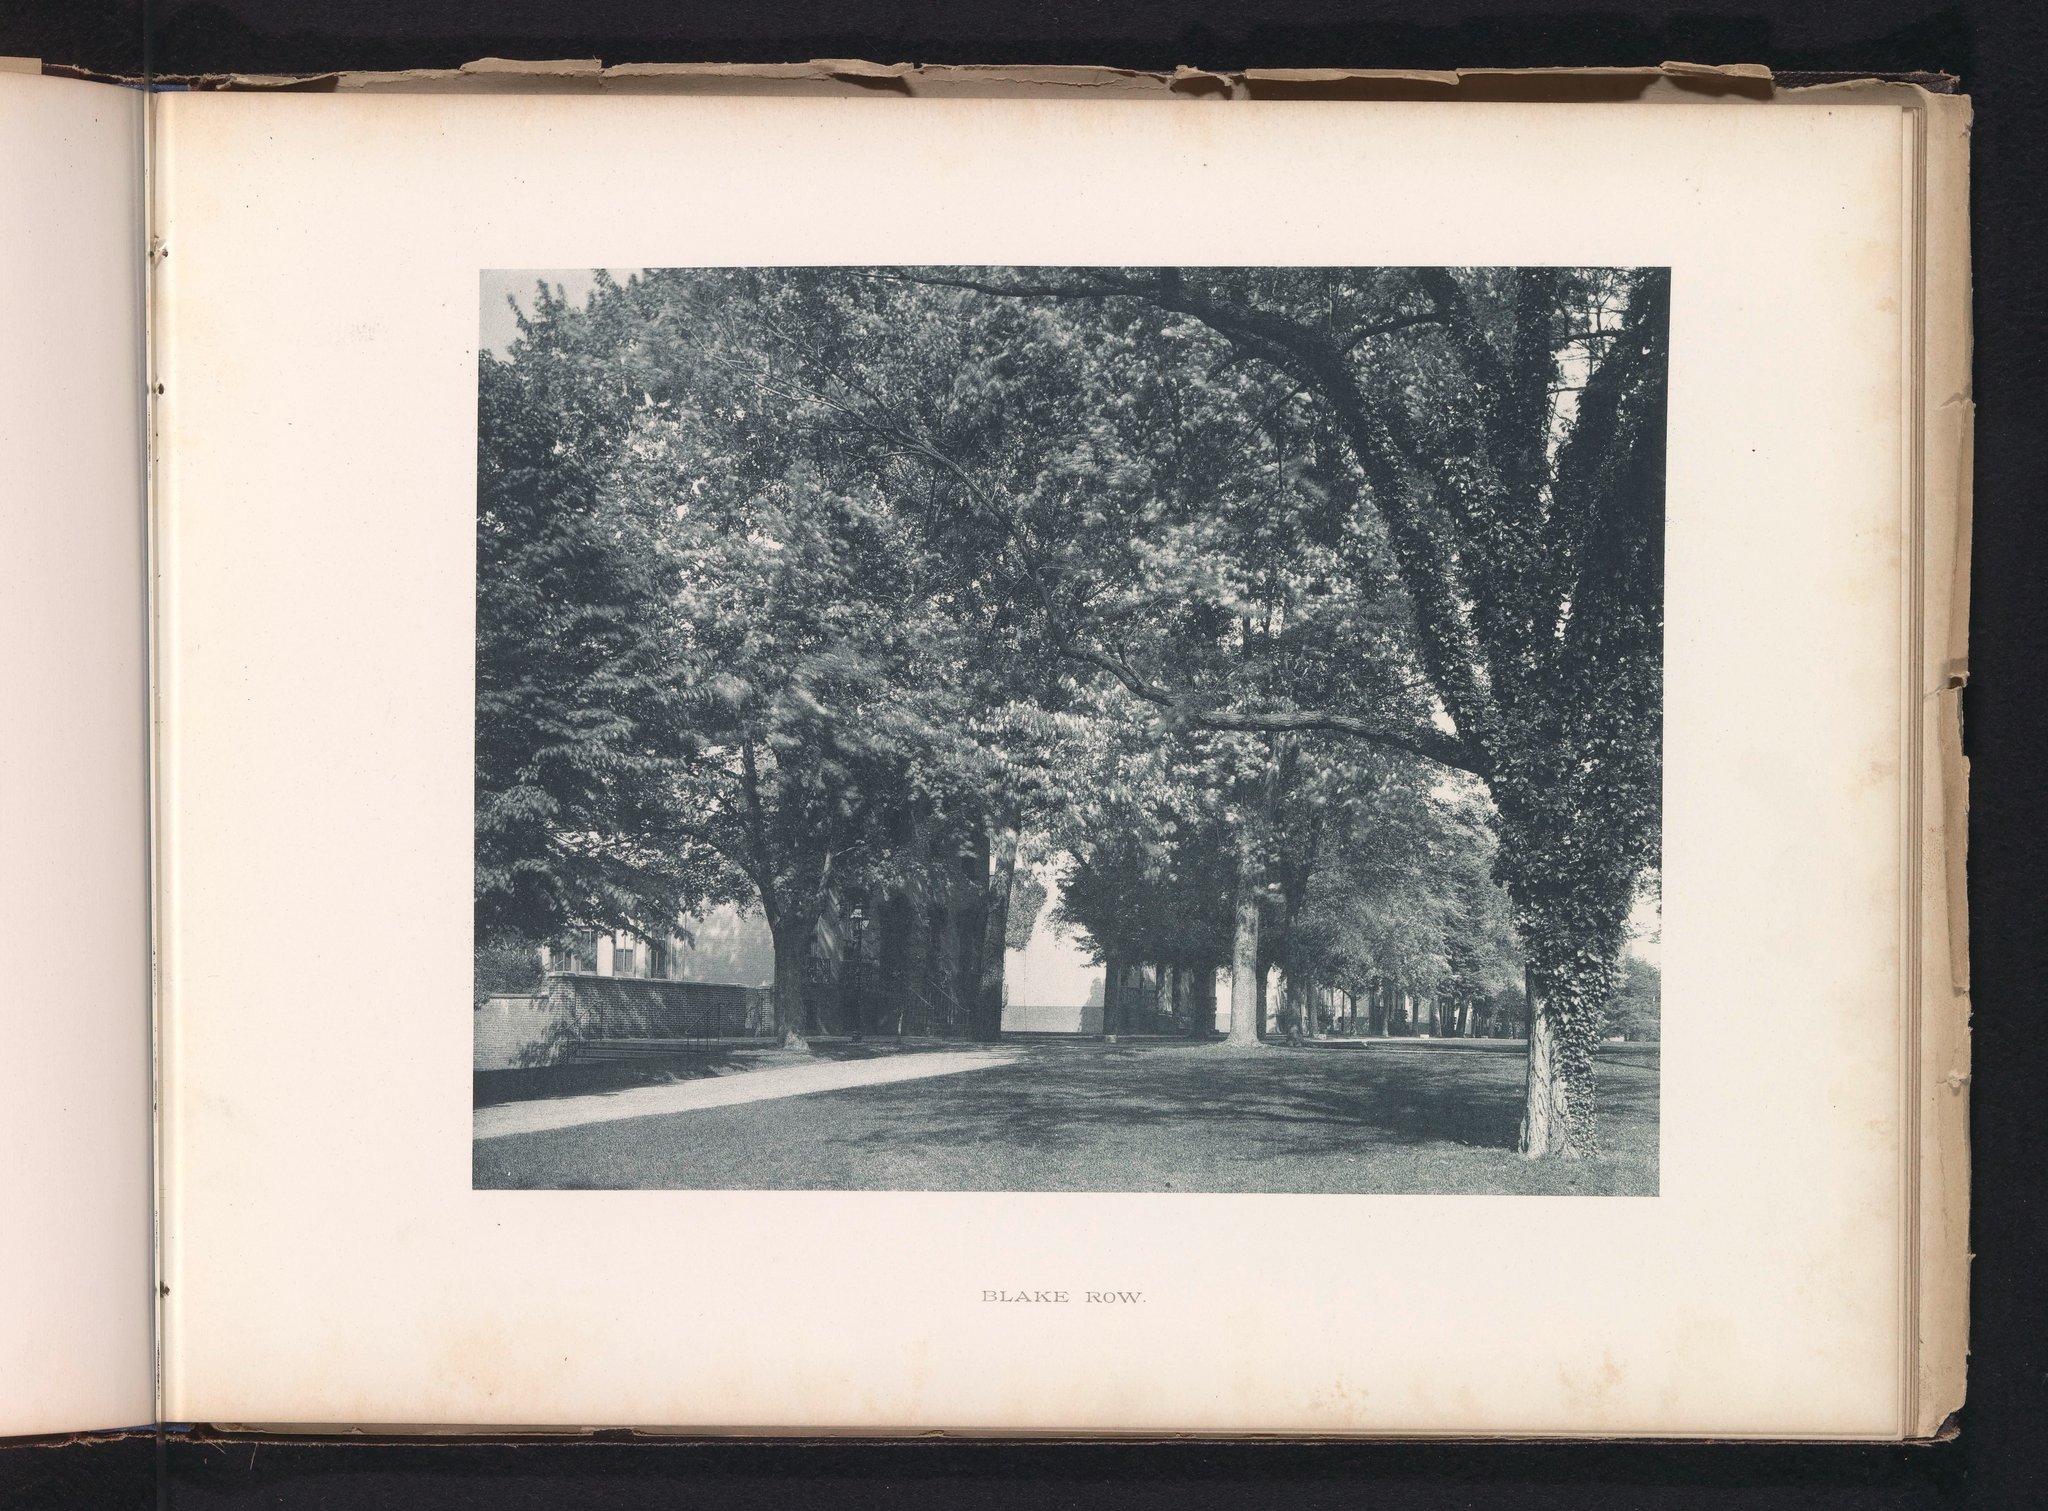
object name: photograph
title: Blake Row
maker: edward h. hart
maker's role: publisher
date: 1885-1890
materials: paper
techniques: photograph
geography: new york city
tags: military academy, façade (of house or building)